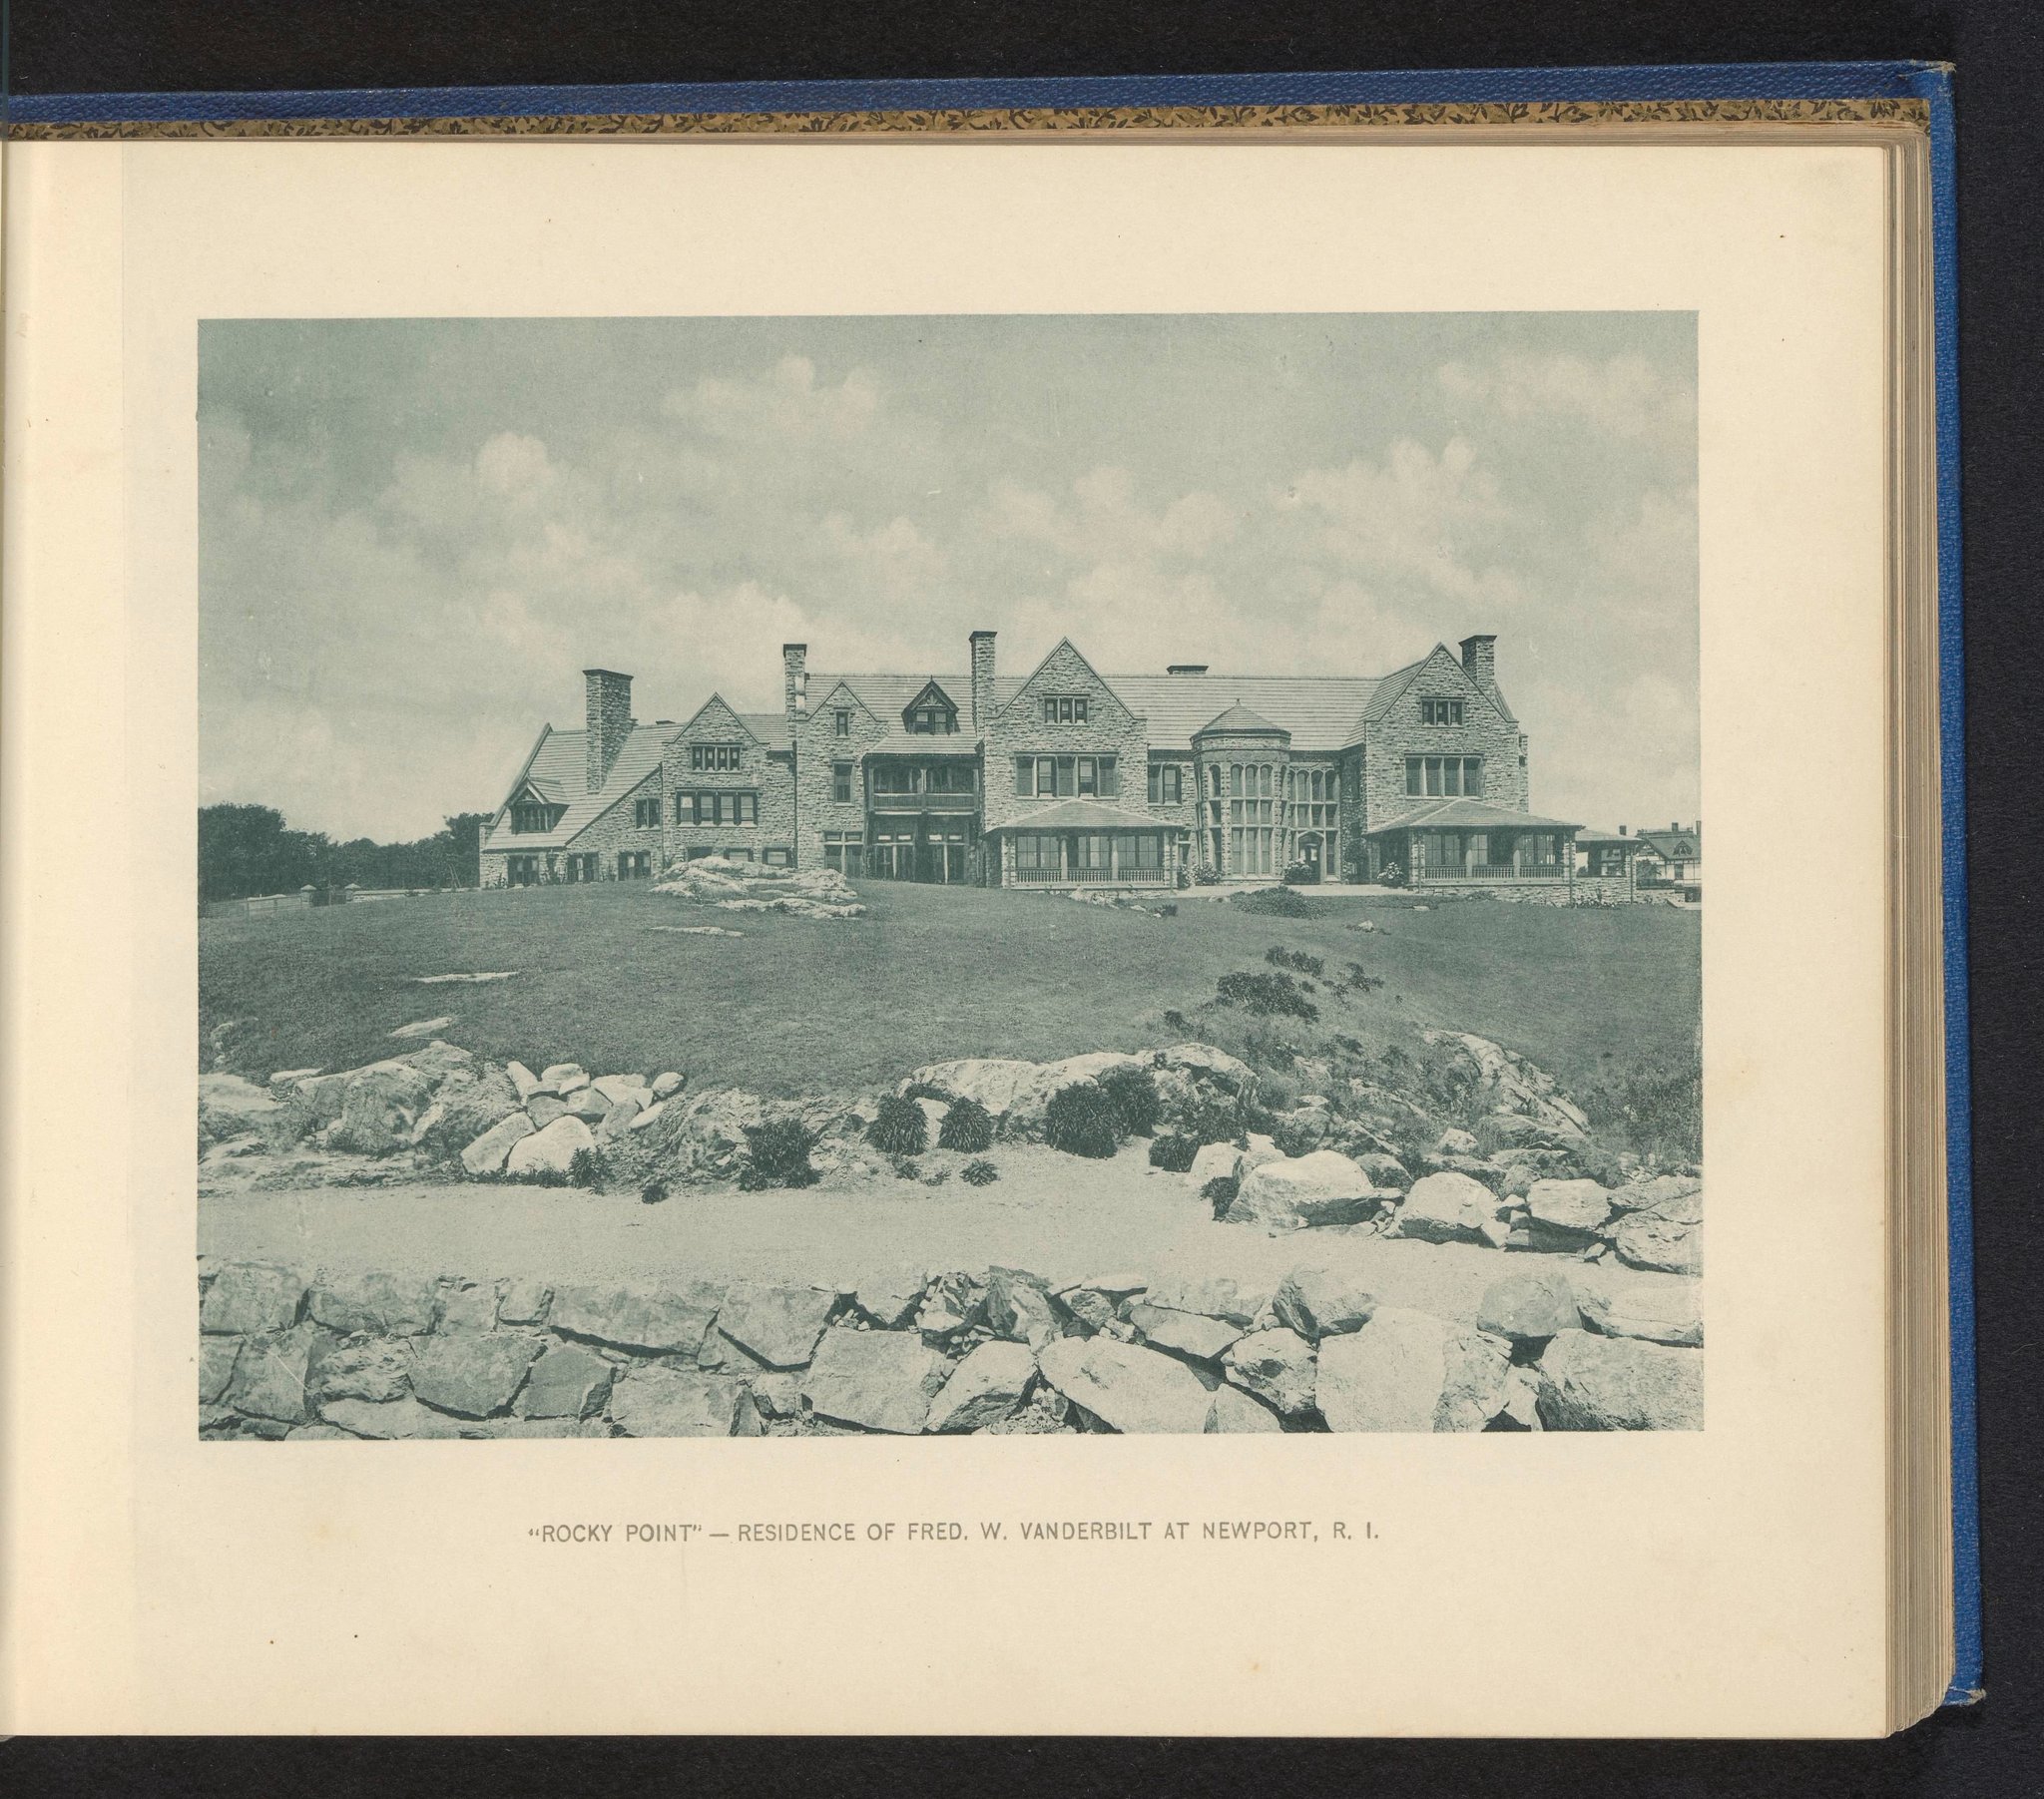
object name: page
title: “Rocky Point” - Residence of Fred. W. Vanderbilt at Newport, R. I.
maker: Anonymous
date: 1883-1893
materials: paper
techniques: photograph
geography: newport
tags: villa